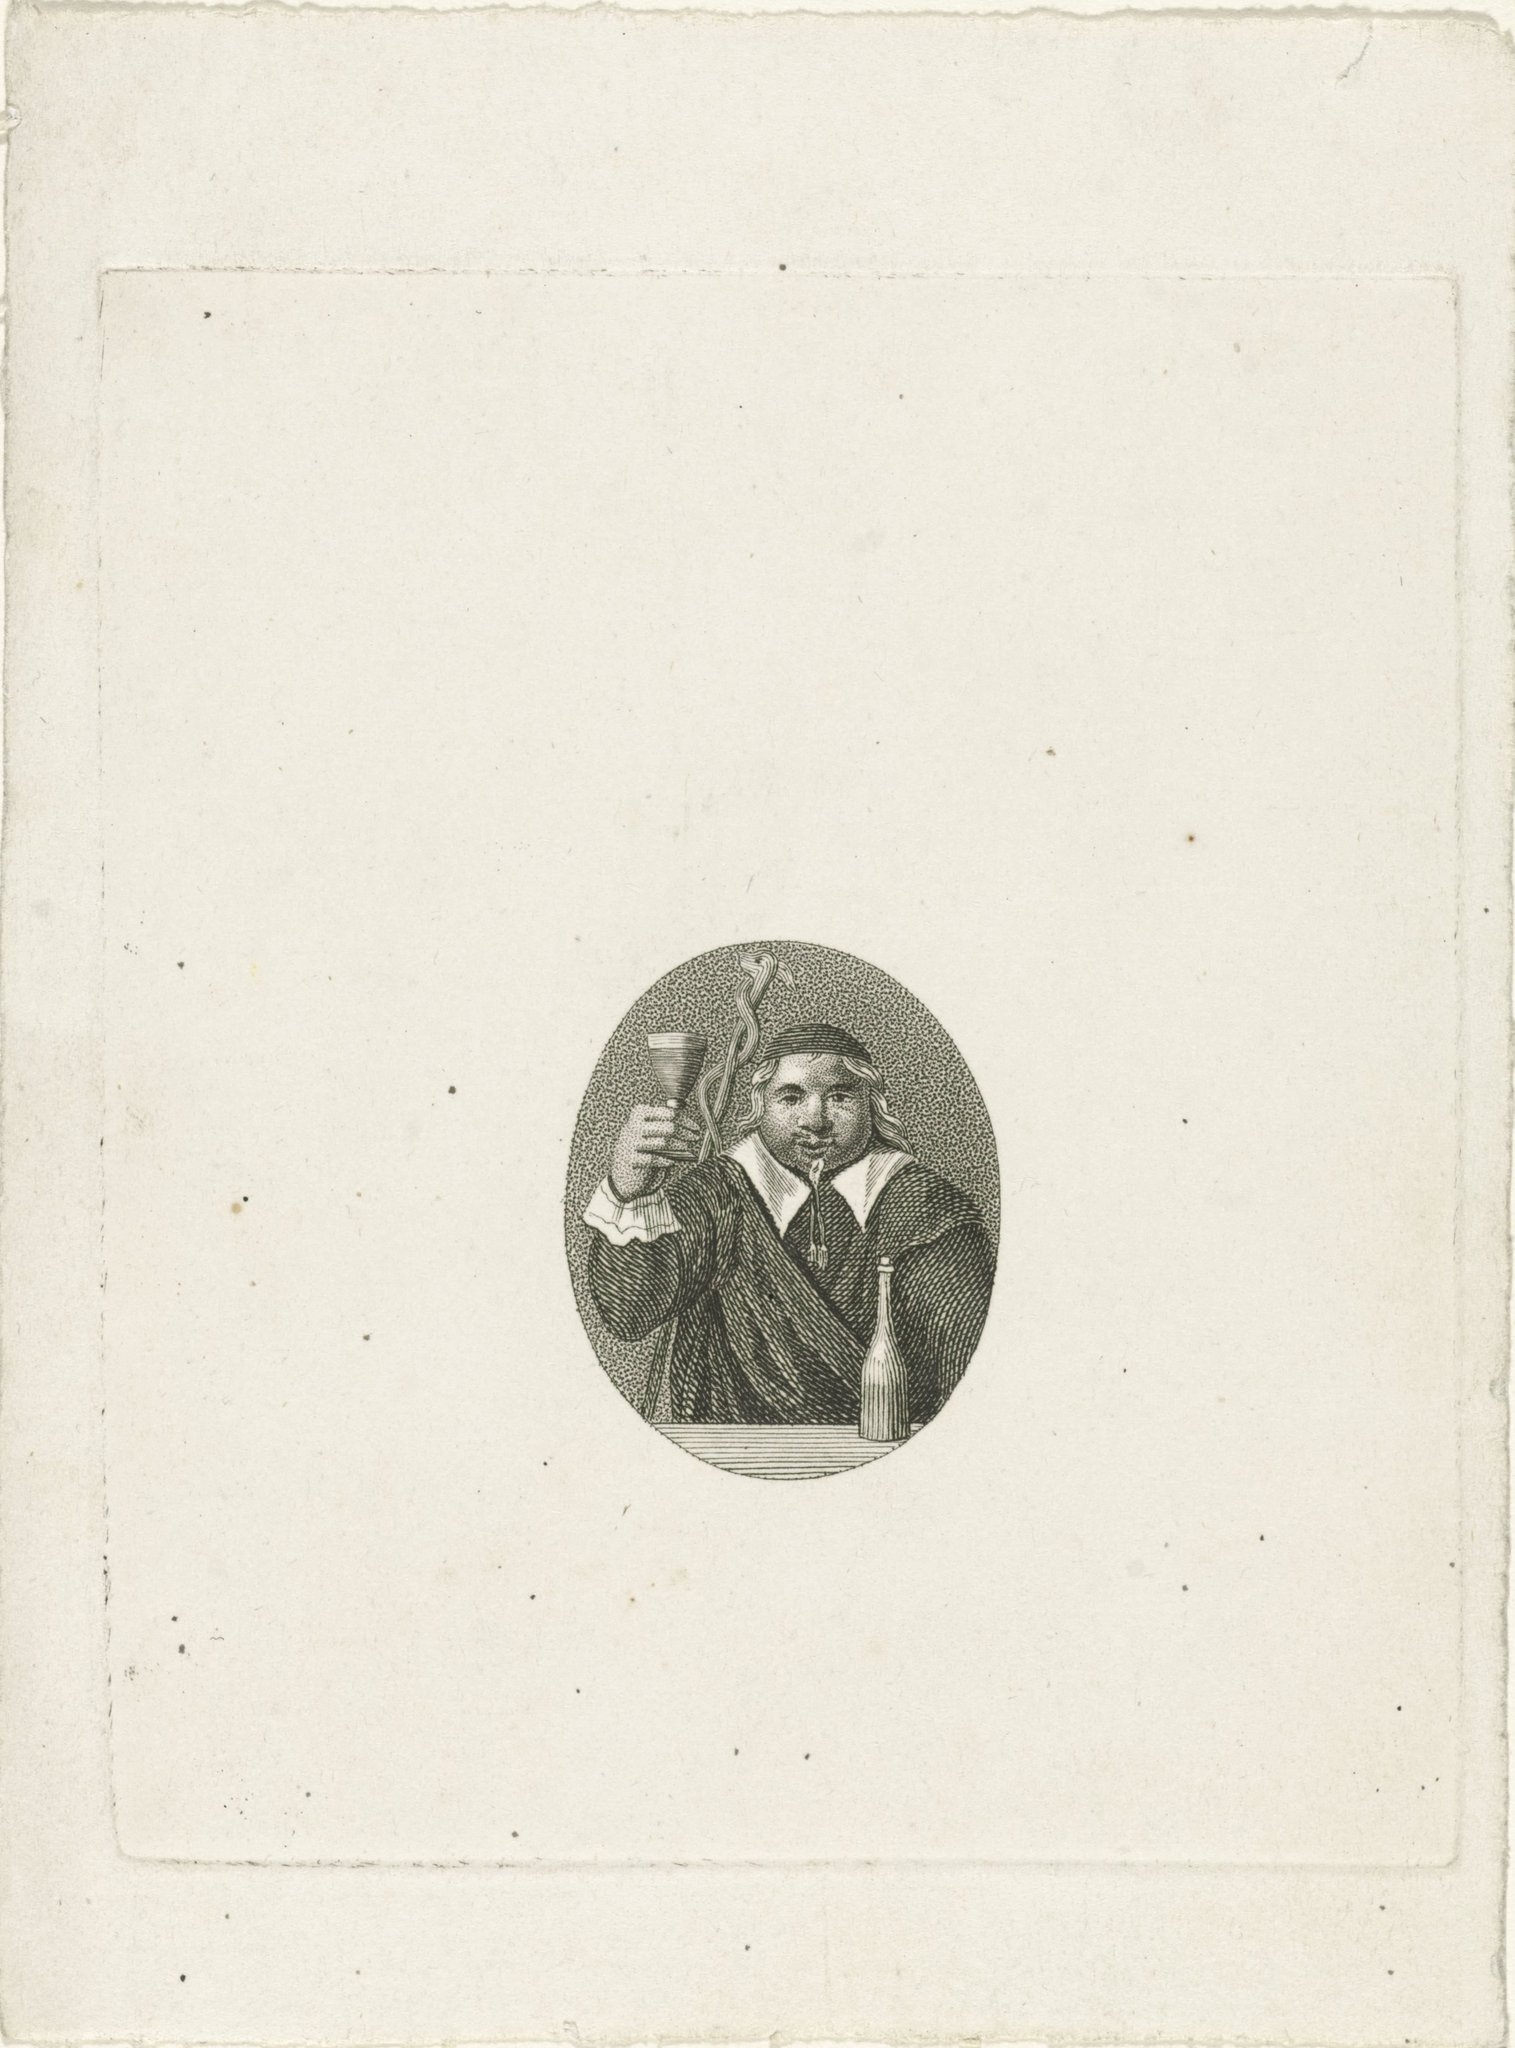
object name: print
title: Portret van dokter Snel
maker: pieter van der meulen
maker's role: draughtsman, painter, print maker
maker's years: 1780-1858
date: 1822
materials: paper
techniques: etching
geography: amsterdam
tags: glass of wine, aesculapian sign, drinking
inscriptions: collector's mark: Lugt 2228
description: Latere staat gebruikt op de titelpagina van: Walré, Jan van. Loosjes Pz., Adriaan. Democritische tafelliedjes. Haarlem: Vincent Loosjes, 1822.